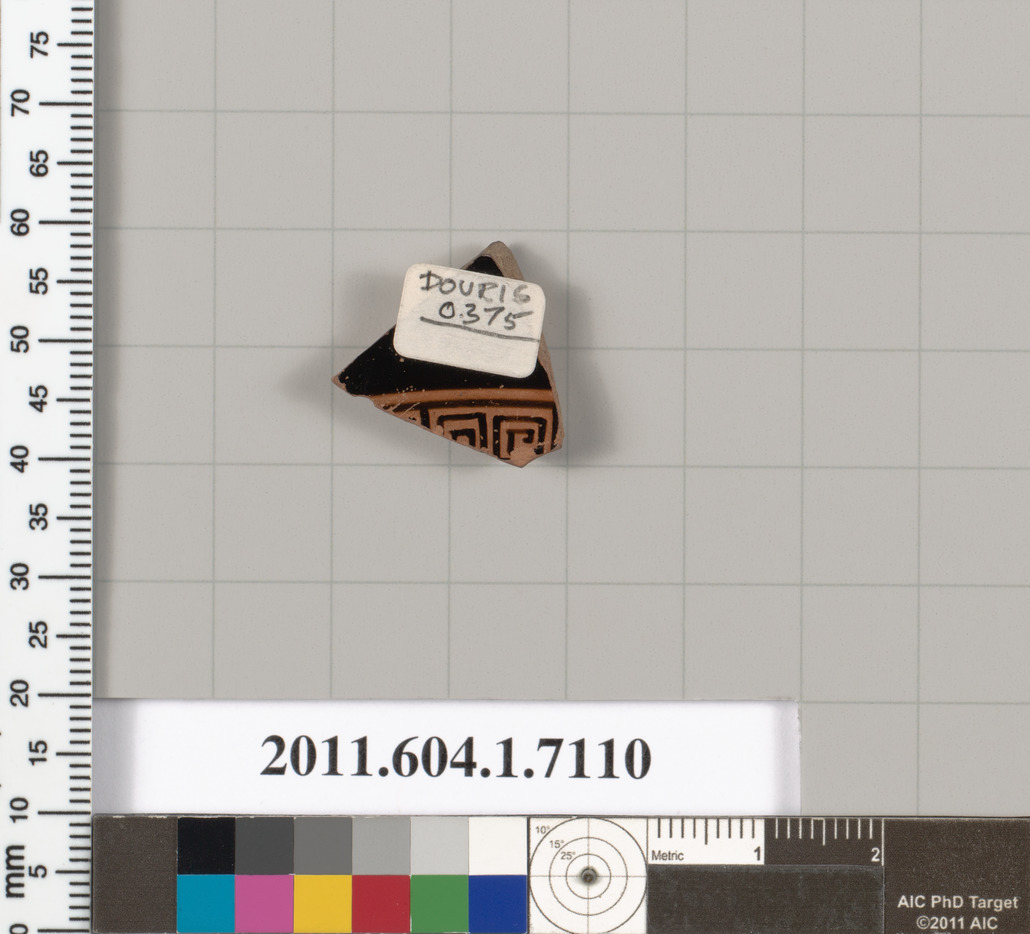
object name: kylix fragment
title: Terracotta fragment of a kylix (drinking cup)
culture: greek, attic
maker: douris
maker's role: artist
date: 500-480 BCE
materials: terracotta